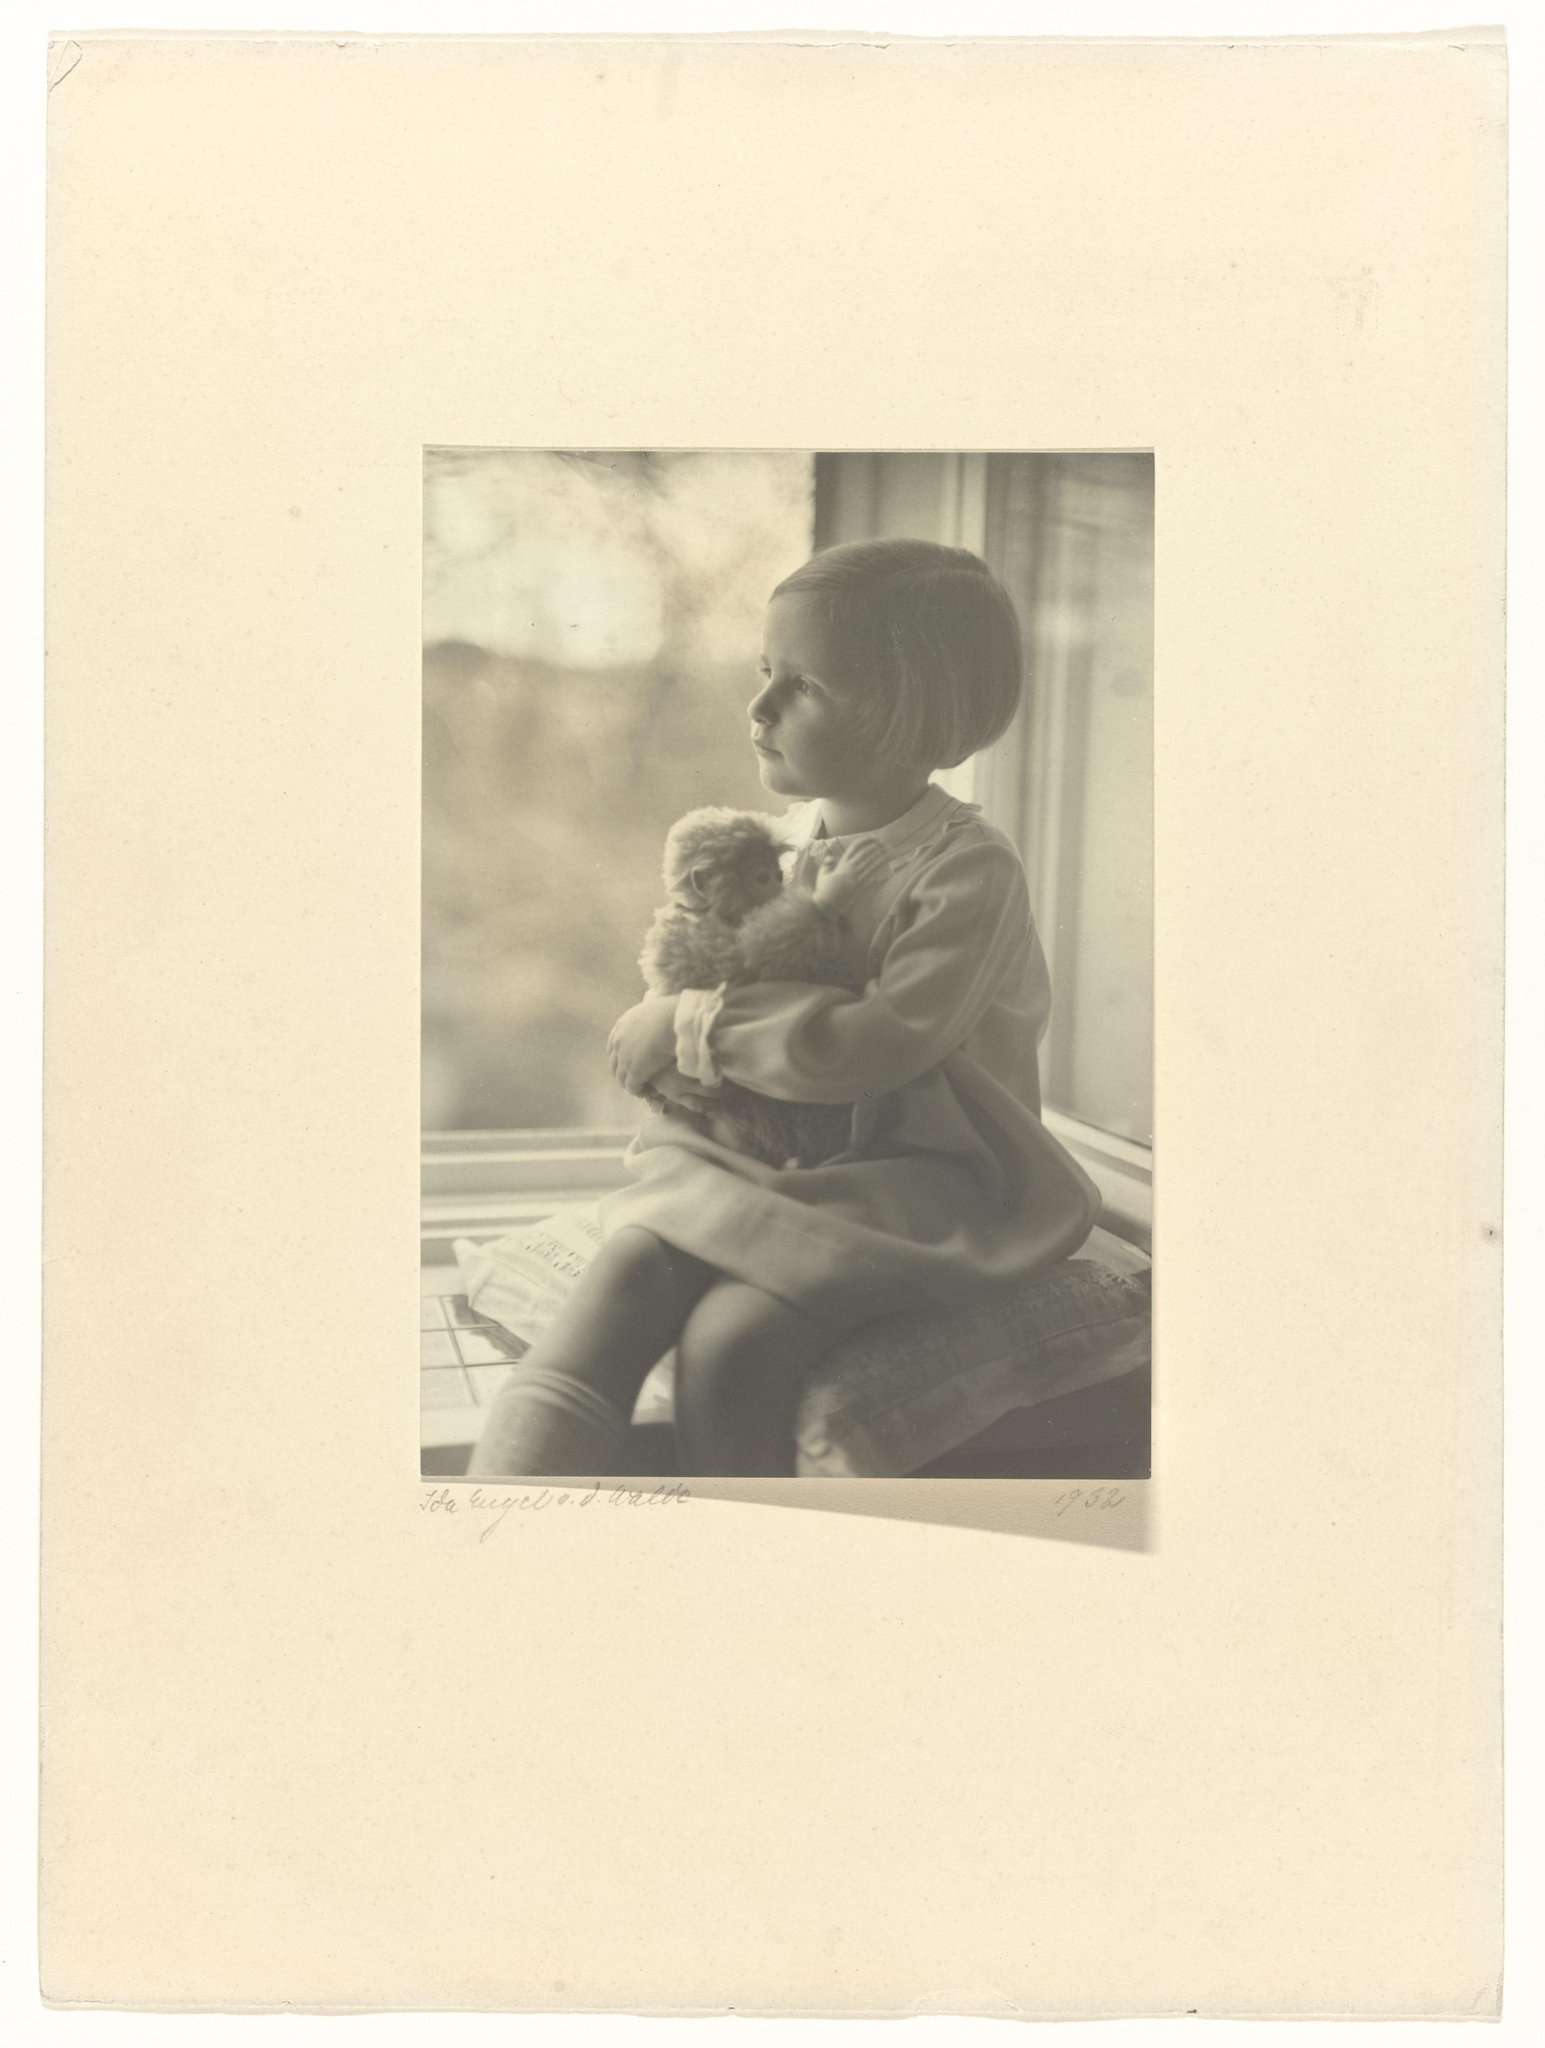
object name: photograph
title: Passe-partout van Isabel Wachenheimer met een knuffel in haar hand, 1932, Stuttgart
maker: Anonymous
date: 1932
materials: photographic support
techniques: gelatin silver print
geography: stuttgart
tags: leiden, isabel wachenheimer-elon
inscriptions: inscription: ‘die Engel a.d. walde//Isabel Wachenheimer’